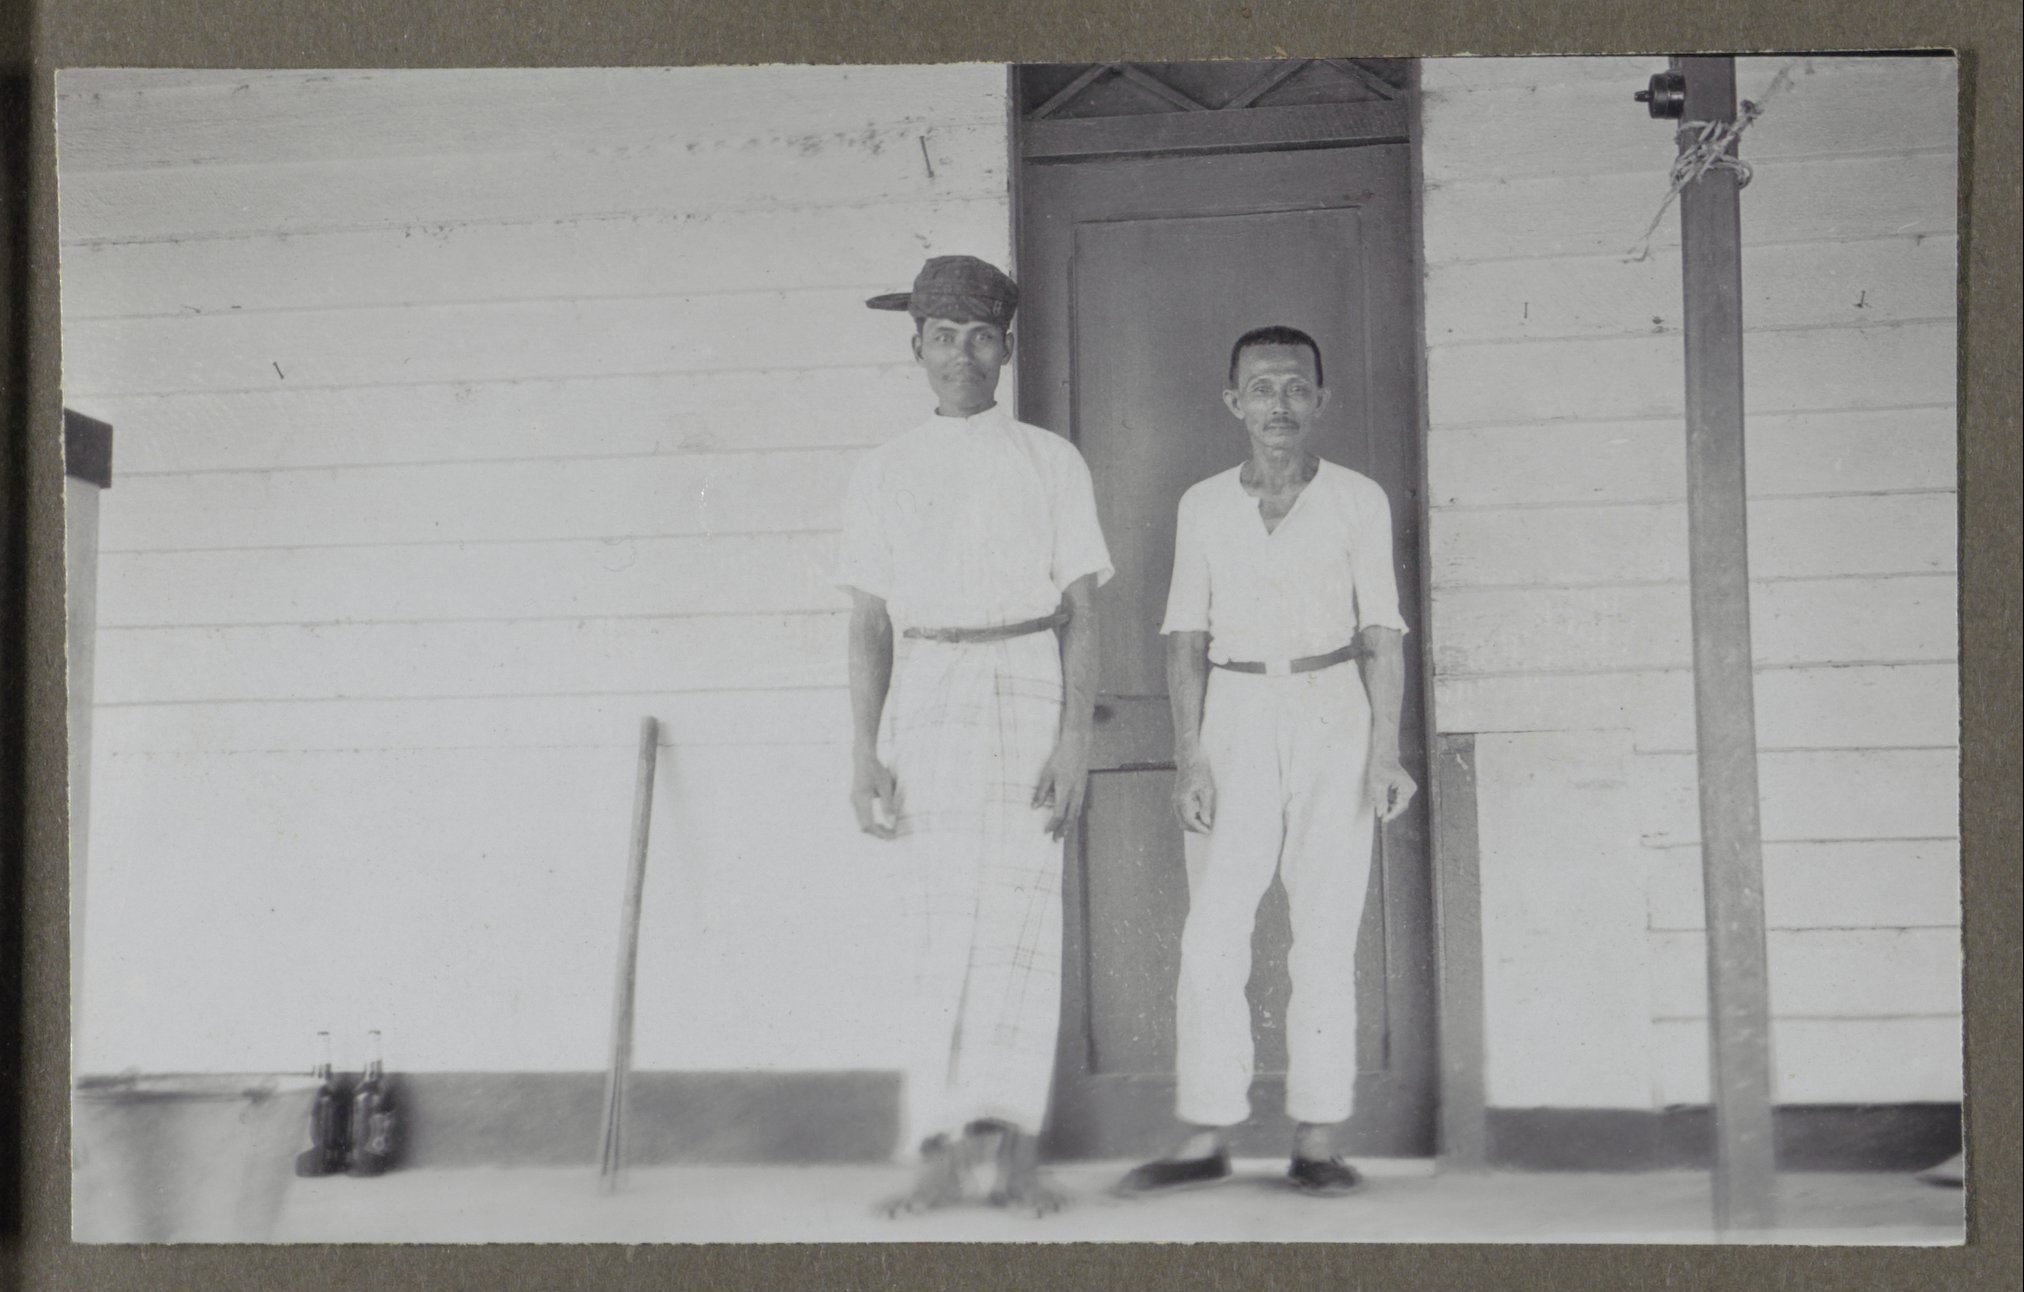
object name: photograph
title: Twee Indische mannen staand voor een deur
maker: Anonymous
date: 1920-1930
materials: photographic support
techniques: gelatin silver print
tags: dutch east indies, the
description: Onderdeel van familiealbum Nederlands-Indië.